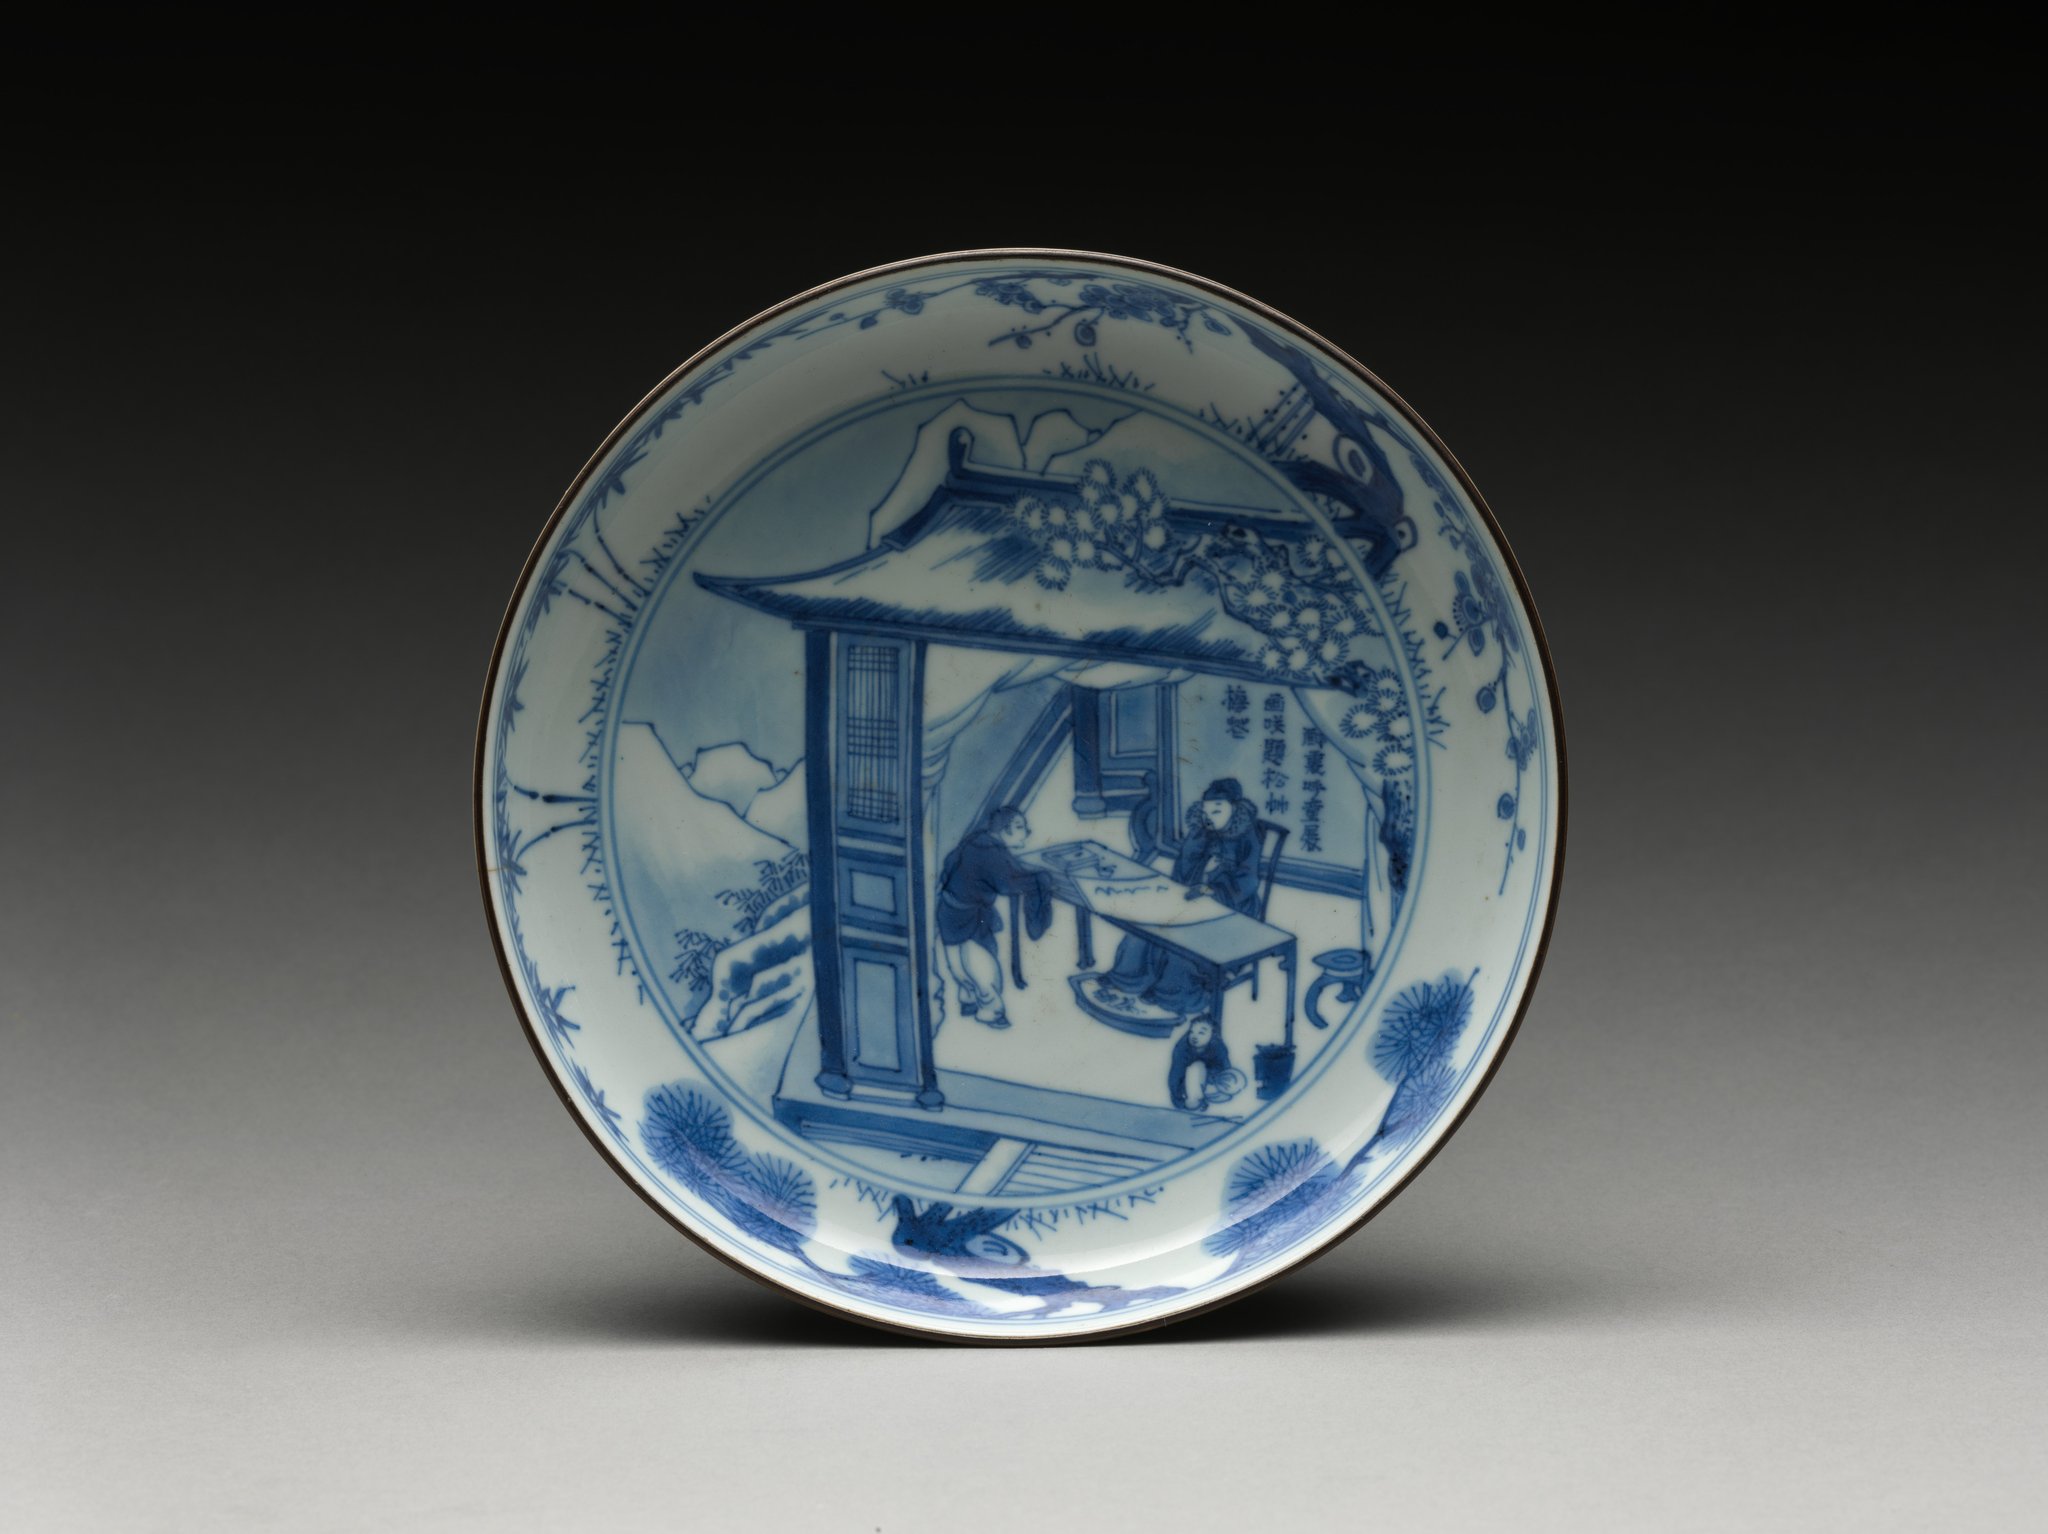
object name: dish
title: Dish with a scholar writing on a snowy night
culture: chinese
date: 1634-1666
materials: cobalt, porcelain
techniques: painting, underglaze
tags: human figures,houses